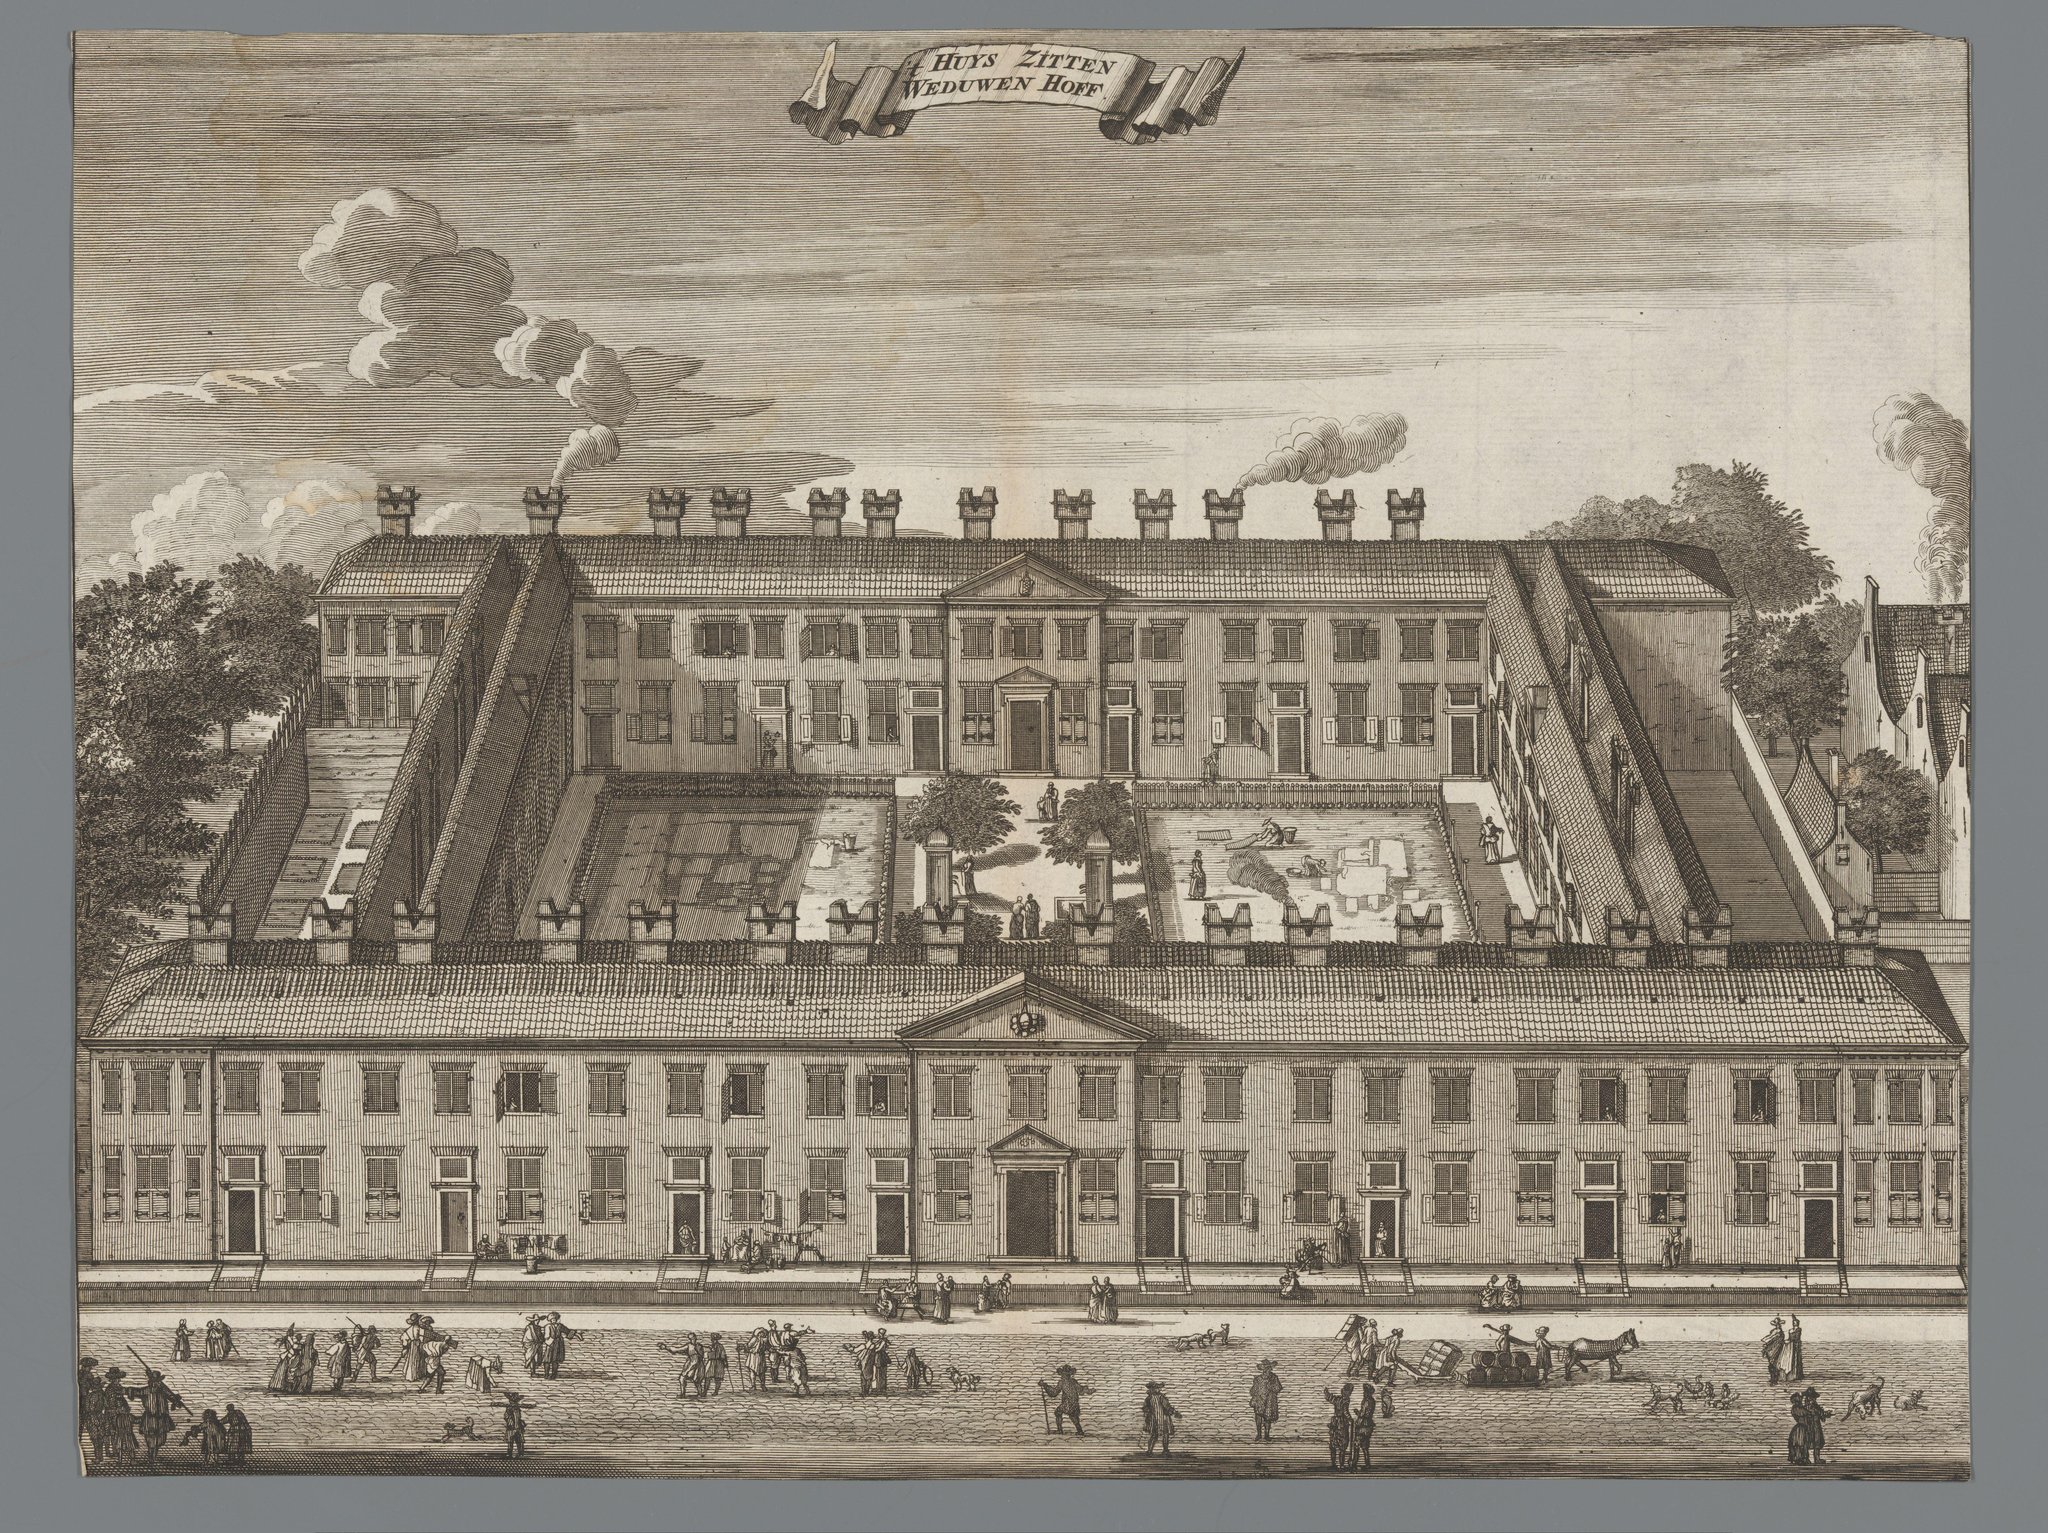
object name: book illustration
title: Vogelvluchtgezicht op het Karthuizerhof te Amsterdam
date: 1726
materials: paper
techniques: engraving, etching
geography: amsterdam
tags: alms-house (dutch: 'hofje'), public welfare, old-people's home, street (+ city(-scape) with figures, staffage)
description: Prent uit: Commelin, Caspar. Beschryvinge van Amsterdam, zynde een naukeruige verhandelinge van desselfs eerste oorspronk uyt den Huyse (…). Amsterdam: Andries van Damme et al., 1726, tussen p. 580 en 581.